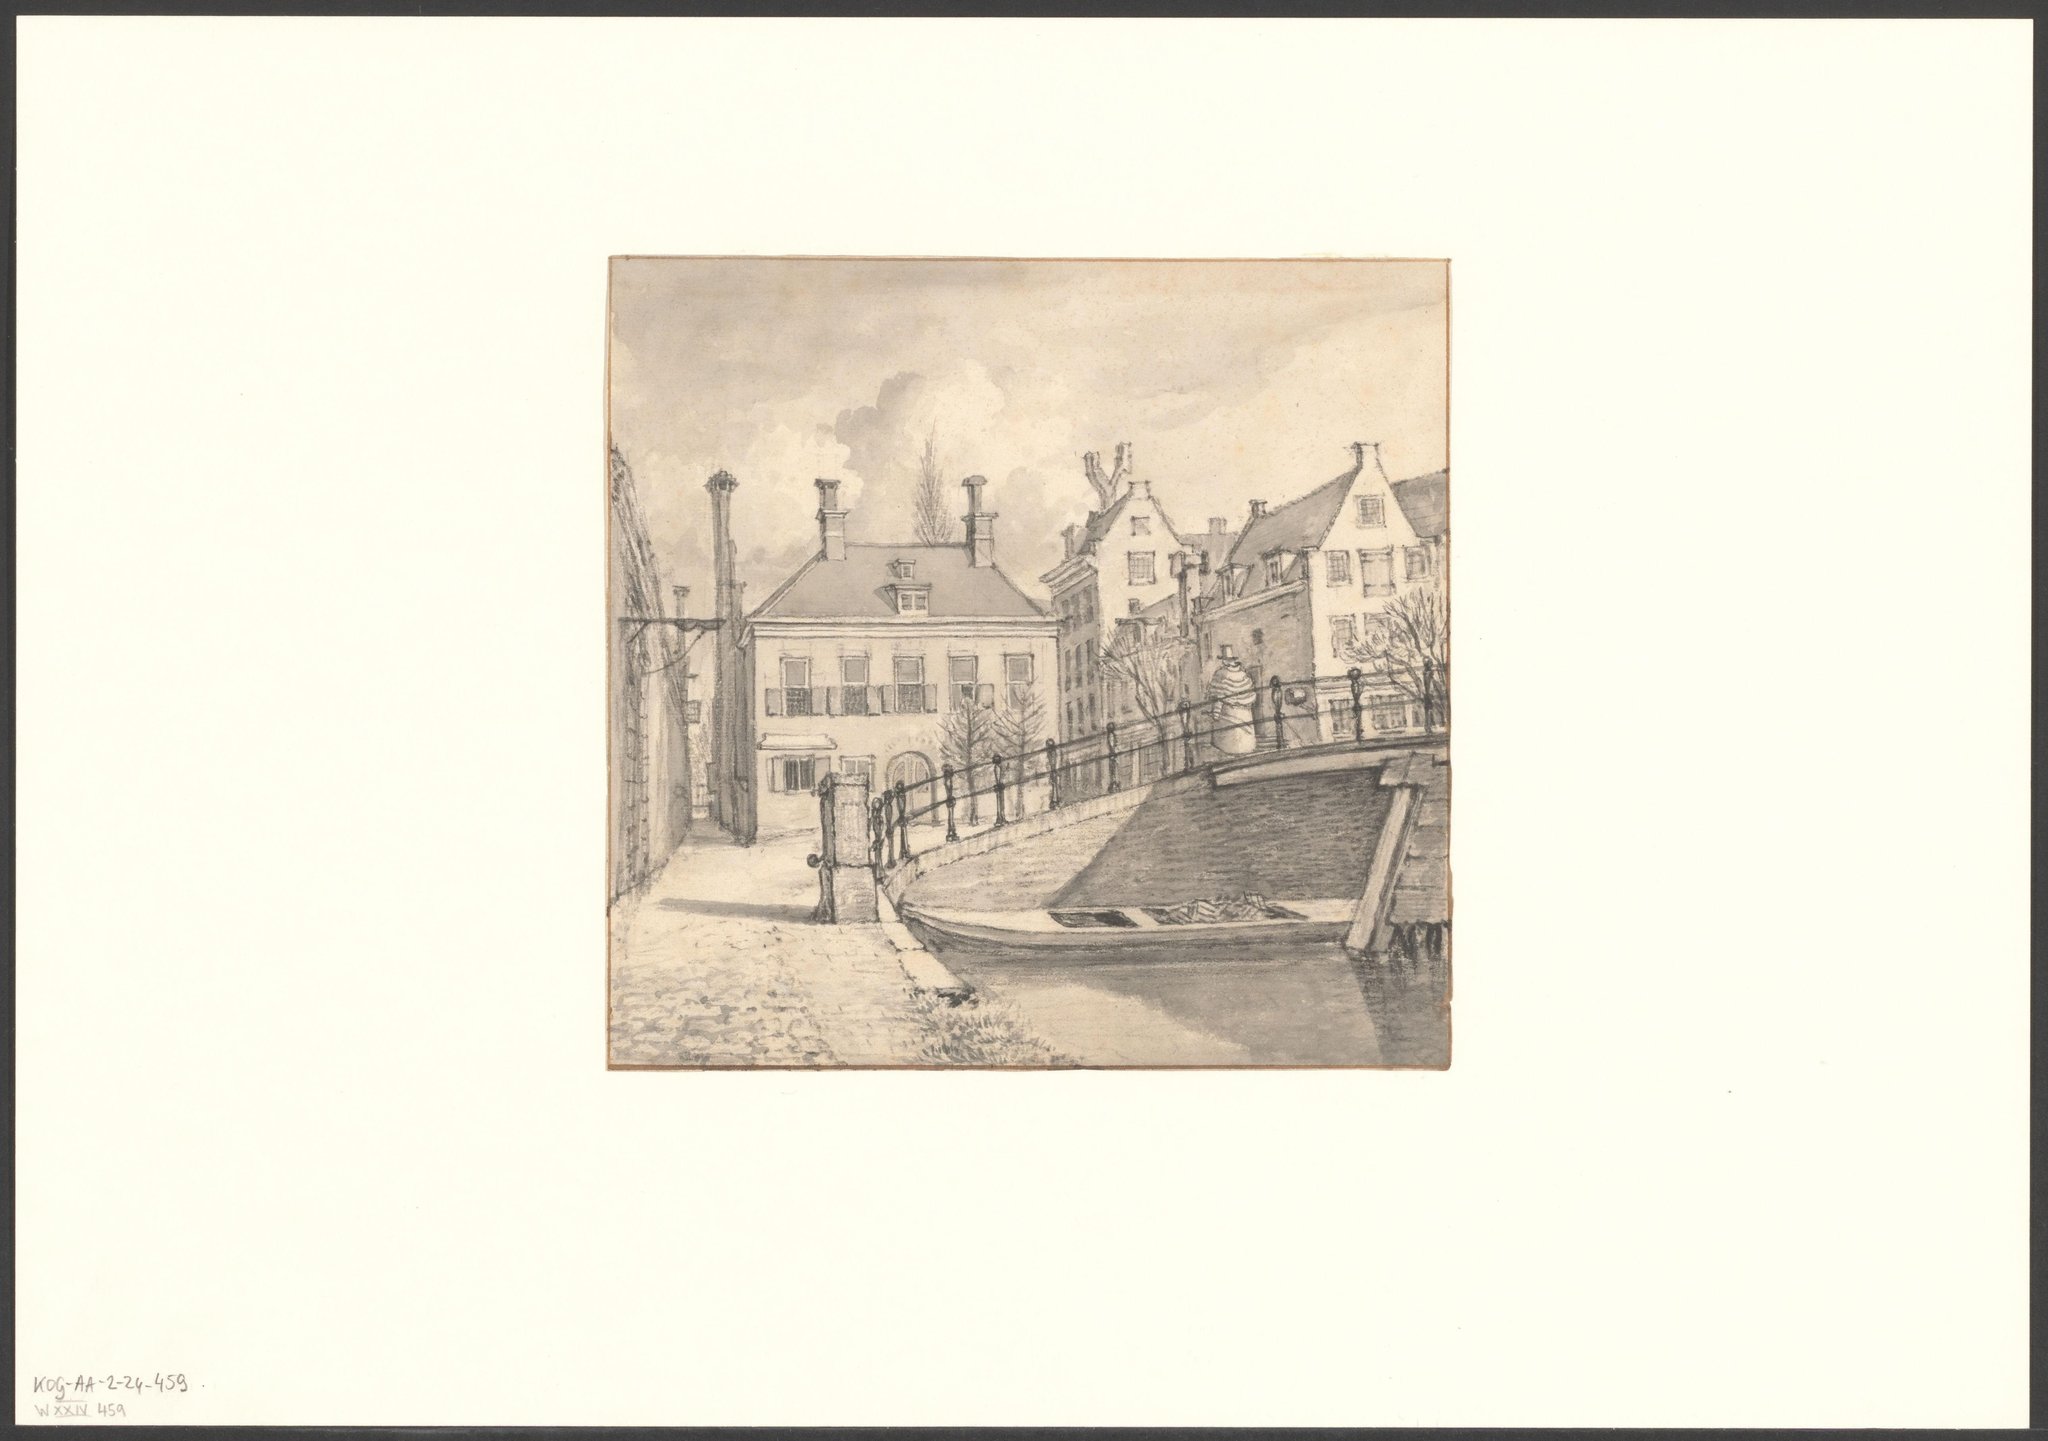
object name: drawing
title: Gezicht op de Leidsegracht met de Hollandsche Manege en de stadsmetseltuin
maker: gerrit lamberts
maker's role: bookseller, draughtsman, print maker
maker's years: 1776-1850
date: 1817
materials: ink, paper, pencil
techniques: brush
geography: amsterdam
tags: city-view in general; 'veduta', canal, façade (of house or building), bridge in city across river, canal, etc.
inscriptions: inscription: ‘Gezigt langs de Manegie / op de Stads Metzeltuin’, collector's mark: Lugt 800a, signature and date: ‘G Lamberts. 1817.’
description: Tekening binnen de Atlas Van Eck ingedeeld op wijknummer 24.